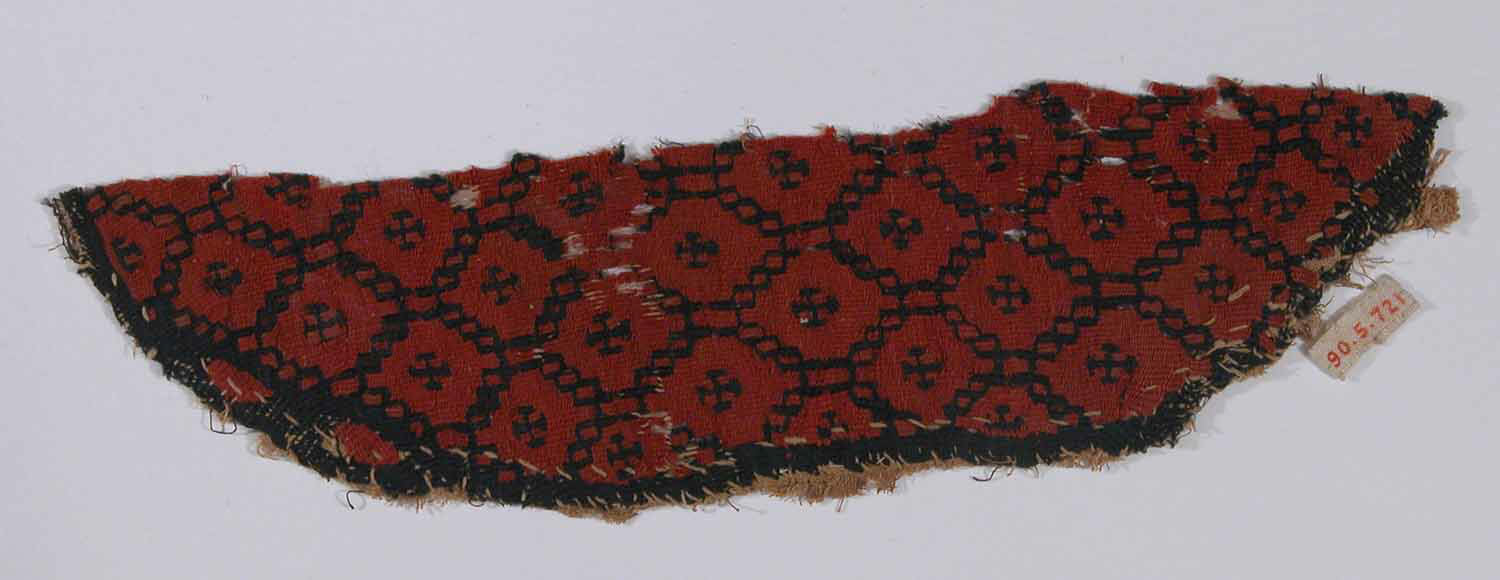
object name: textile fragment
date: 401-600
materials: wool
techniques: weave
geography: egypt